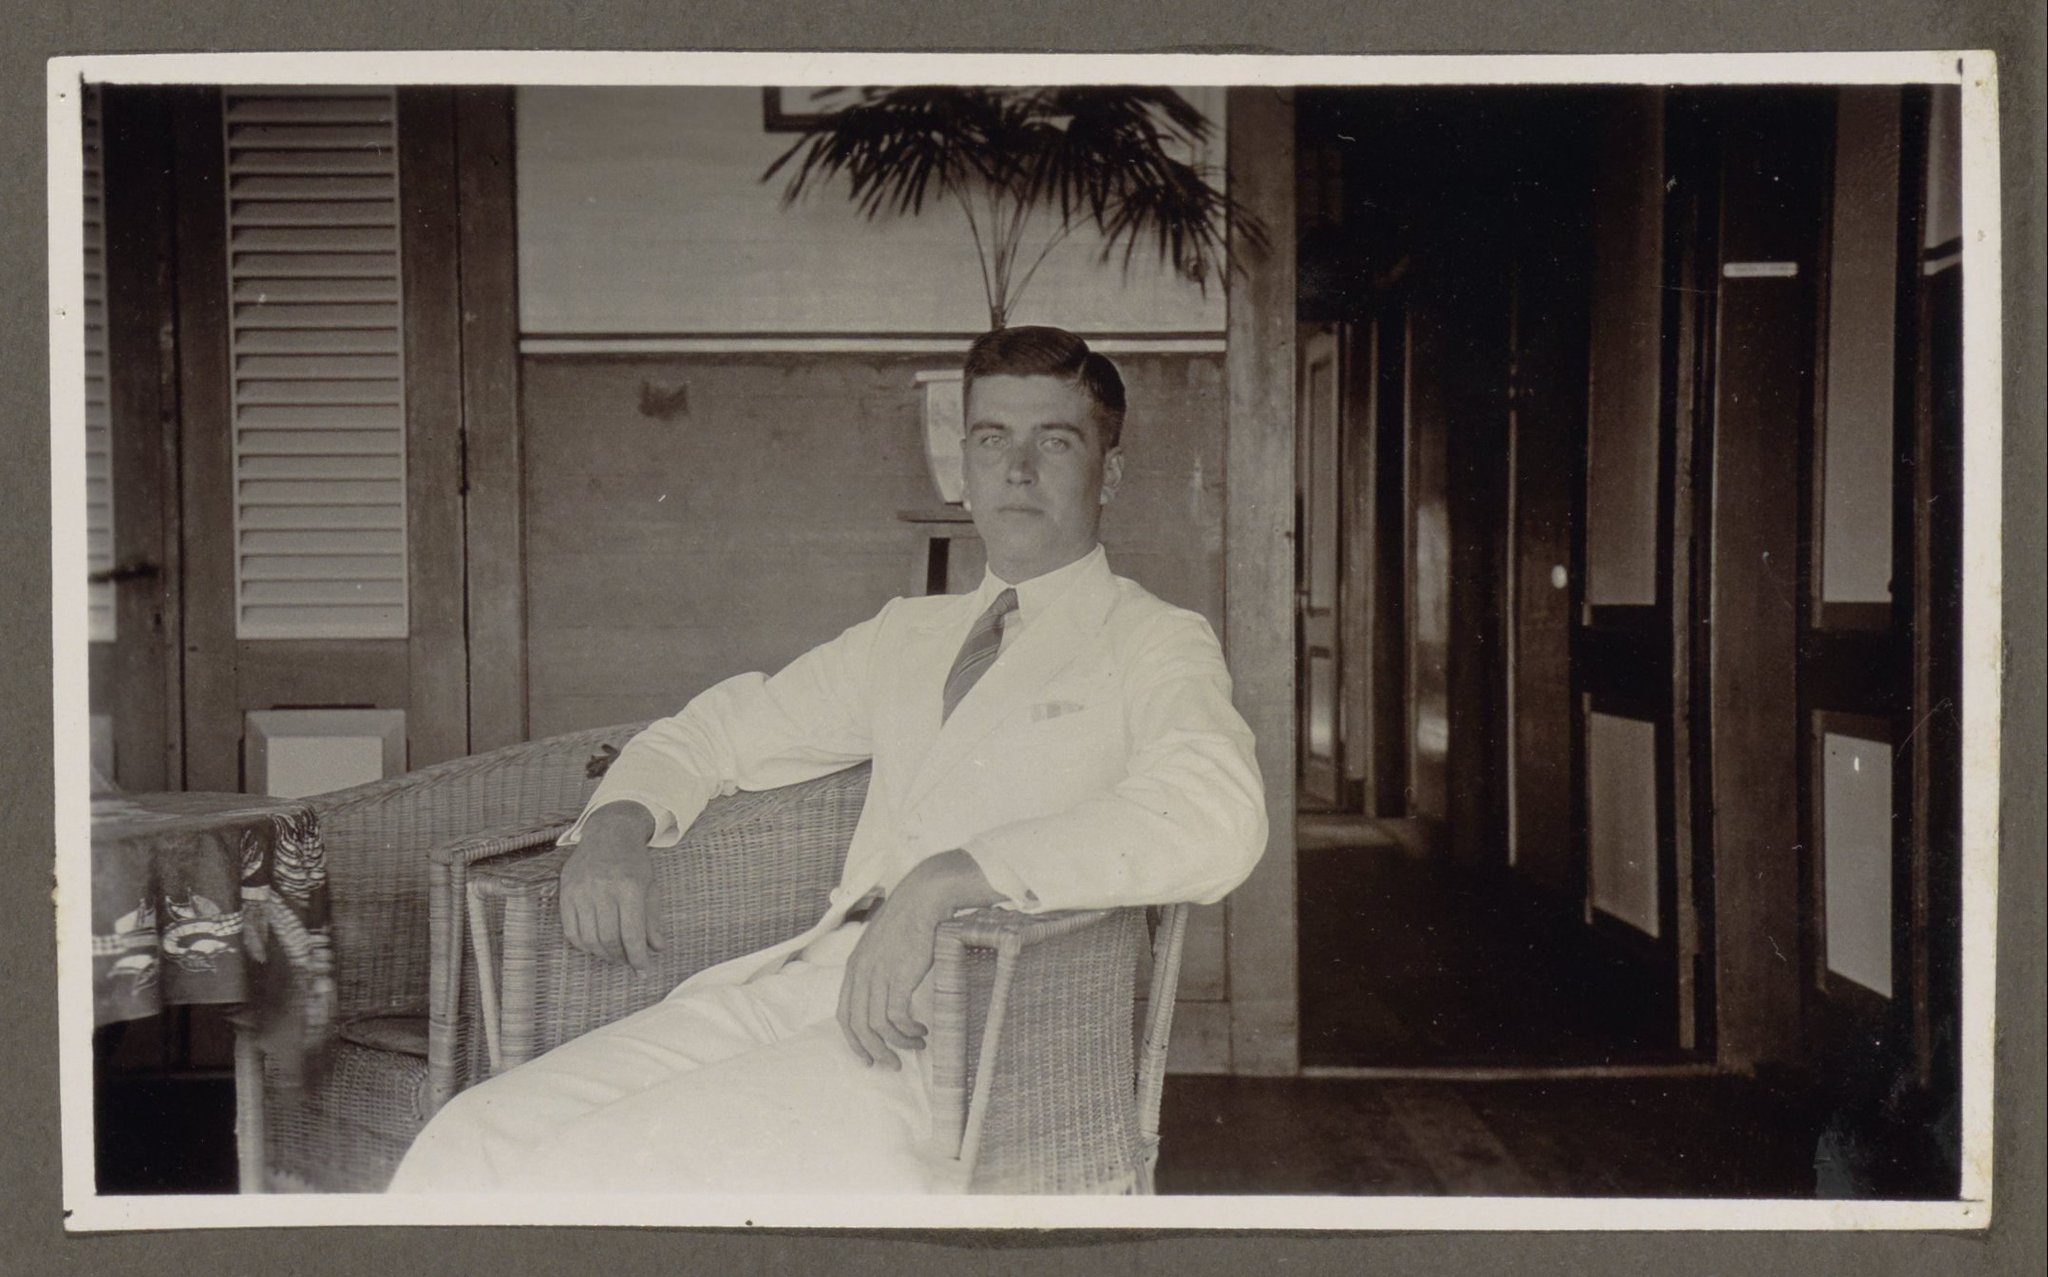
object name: photograph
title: Man in een wit kostuum zittend in een rieten fauteuil, de armen leunend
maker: Anonymous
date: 1920-1930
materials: photographic support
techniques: gelatin silver print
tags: armchair, seat, interior of the house, dutch east indies, the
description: Onderdeel van familiealbum Nederlands-Indië.